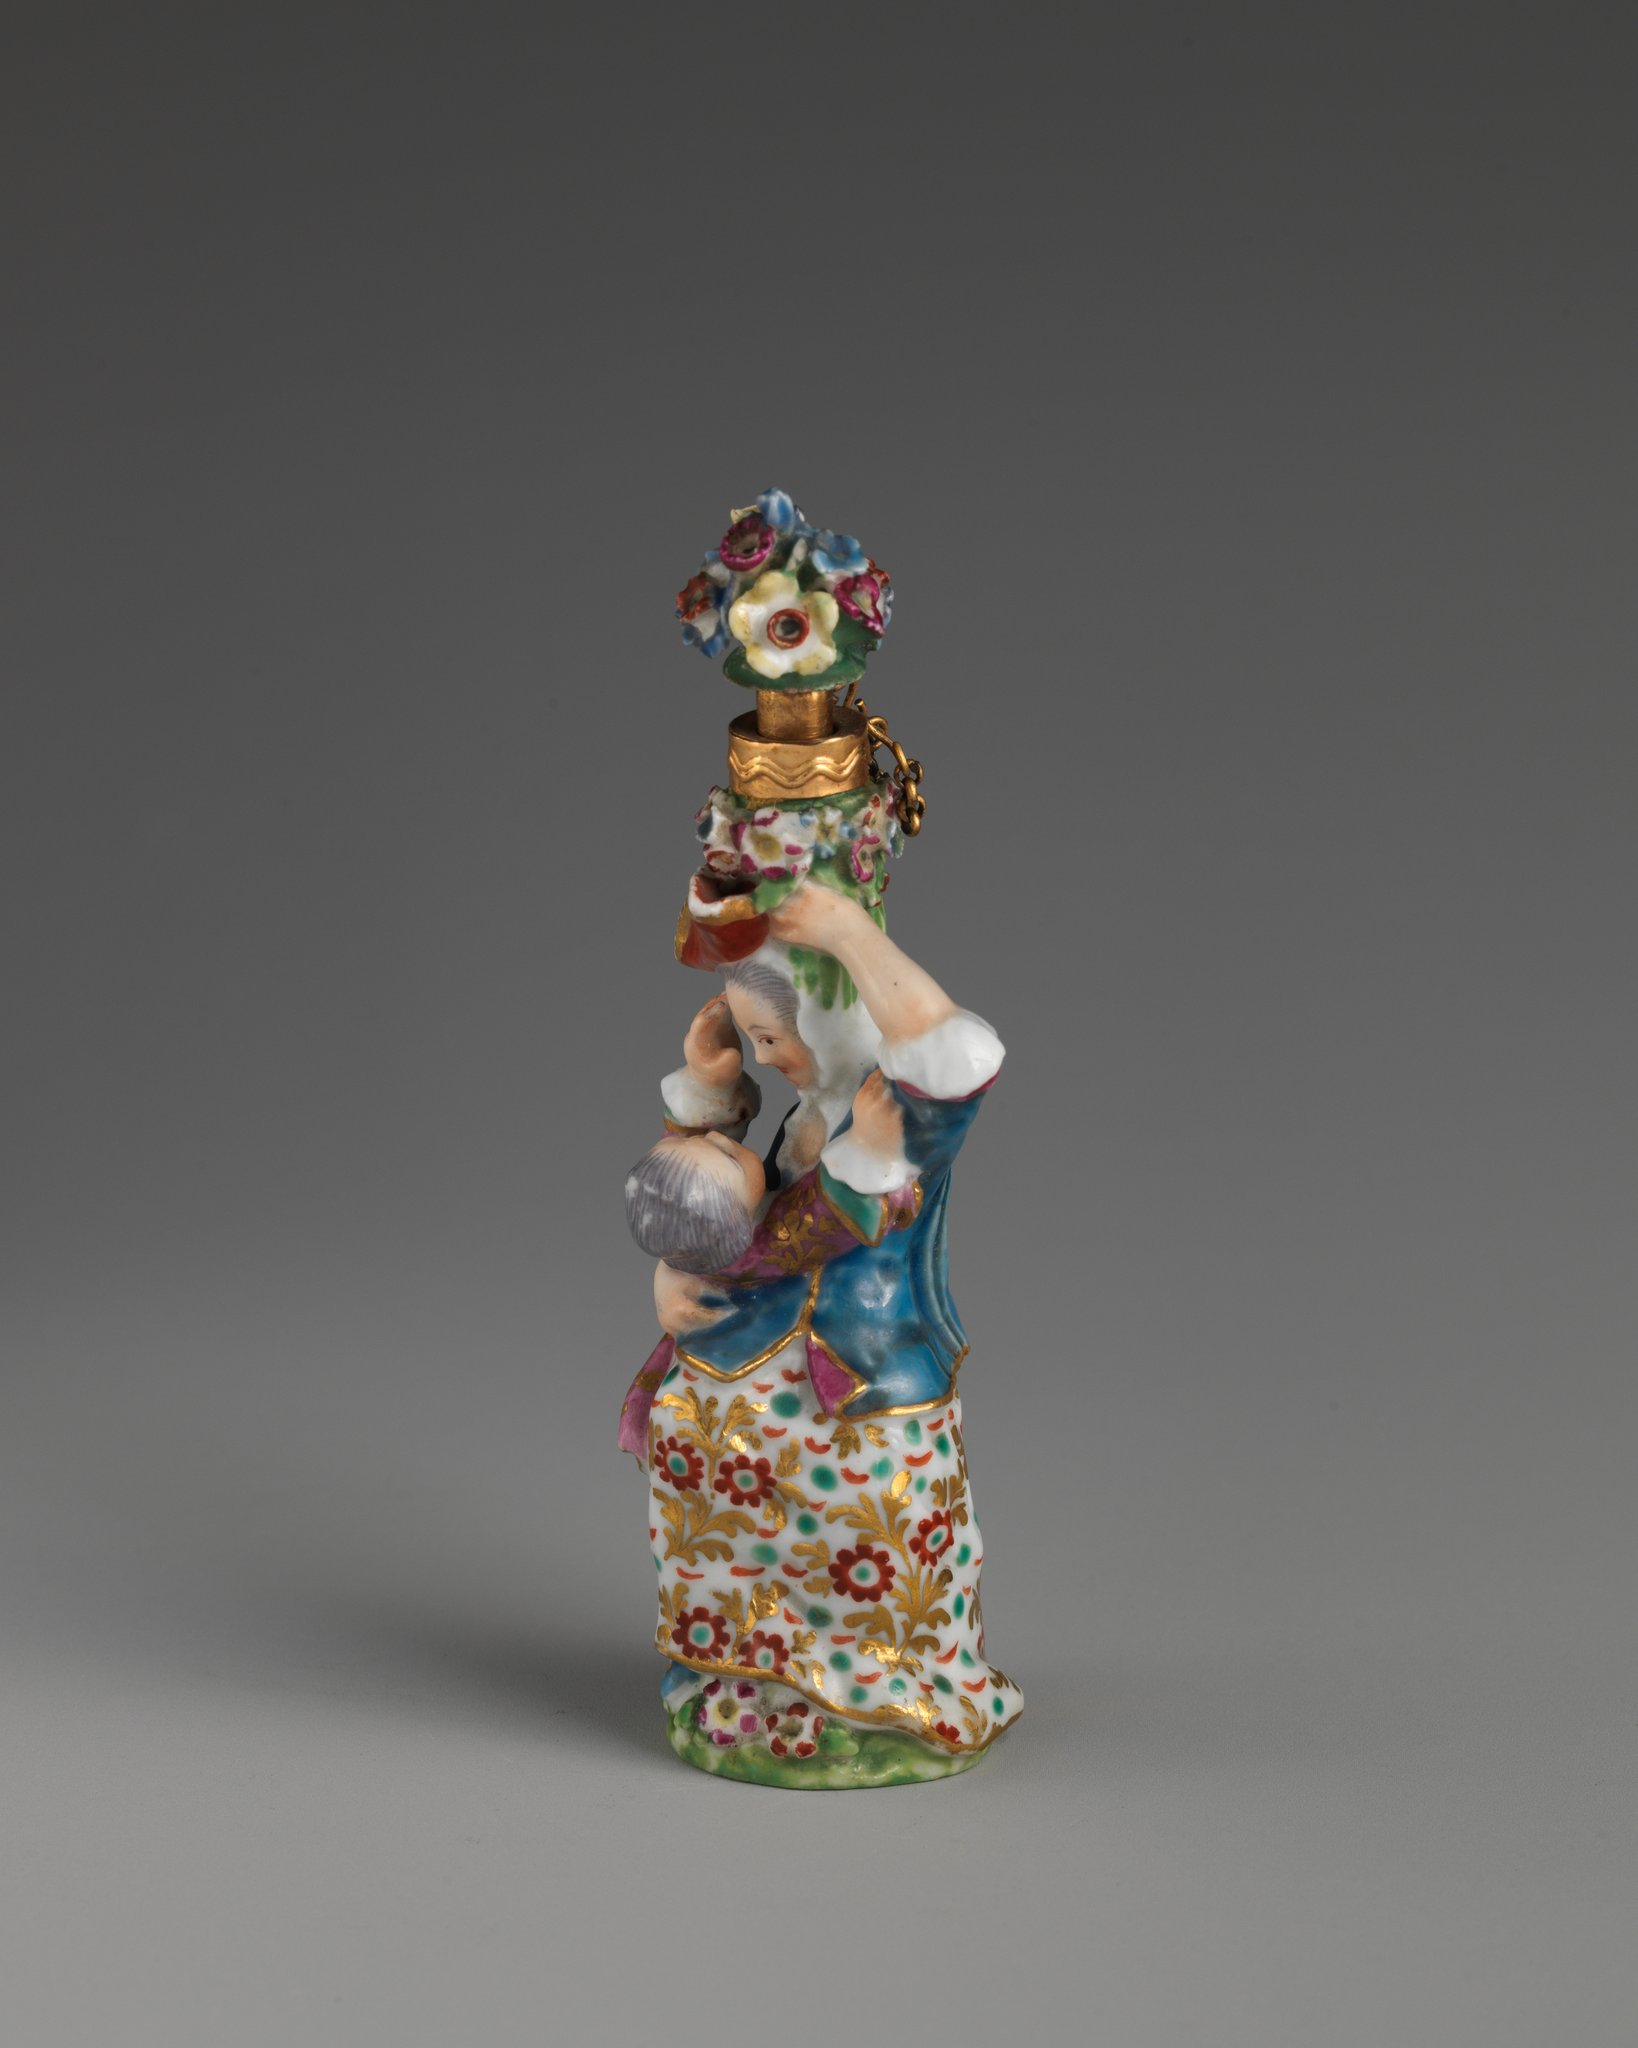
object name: toy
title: Lady with boy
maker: chelsea porcelain manufactory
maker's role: factory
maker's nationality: british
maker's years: 1744-1784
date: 1765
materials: soft paste porcelain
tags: boys,women,flowers